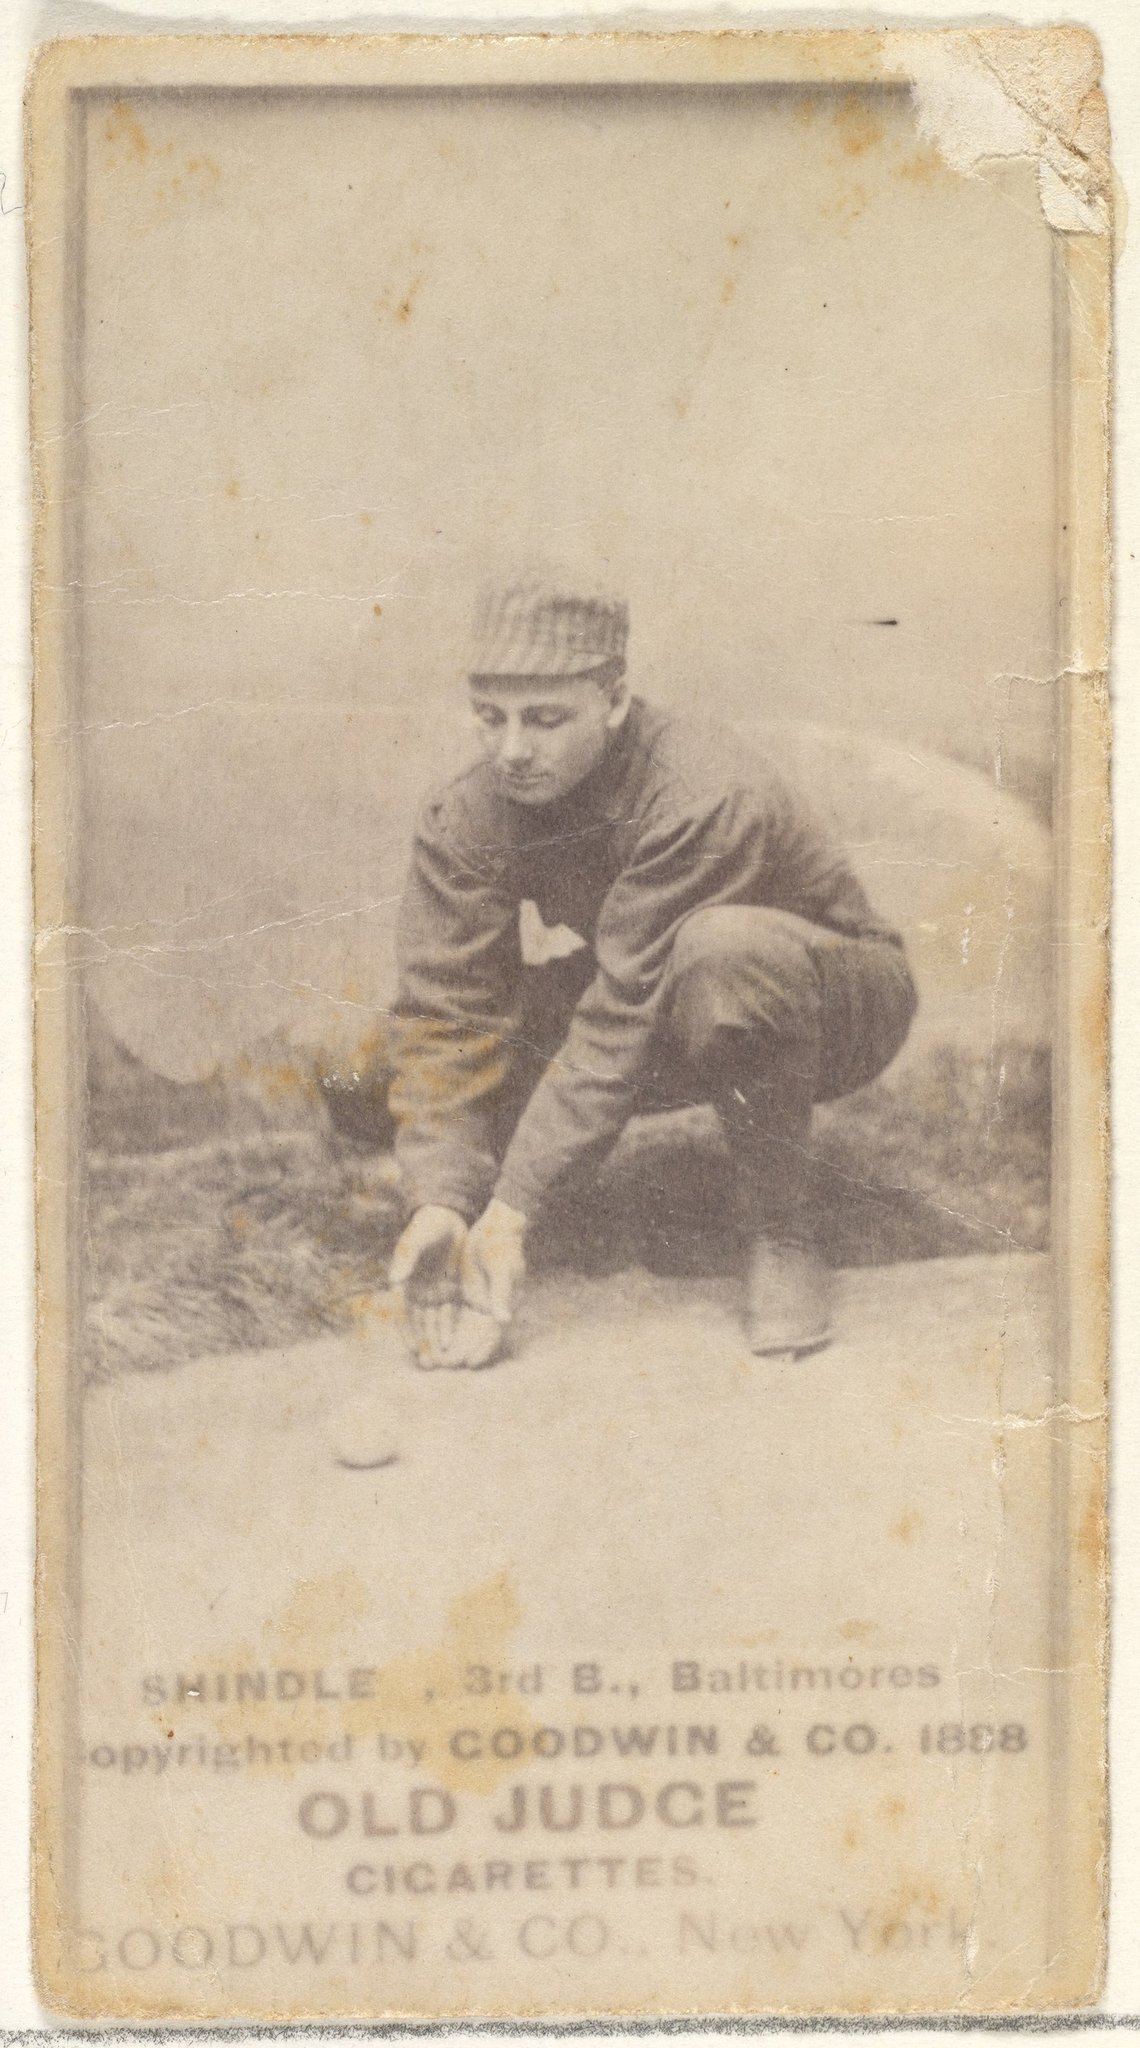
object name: baseball card, photograph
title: Shindle, 3rd Base, Baltimore Orioles, from the Old Judge series (N172) for Old Judge Cigarettes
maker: goodwin & company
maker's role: publisher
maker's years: 1850-1950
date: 1888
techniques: albumen silver print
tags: men,portraits,baseball,athletes